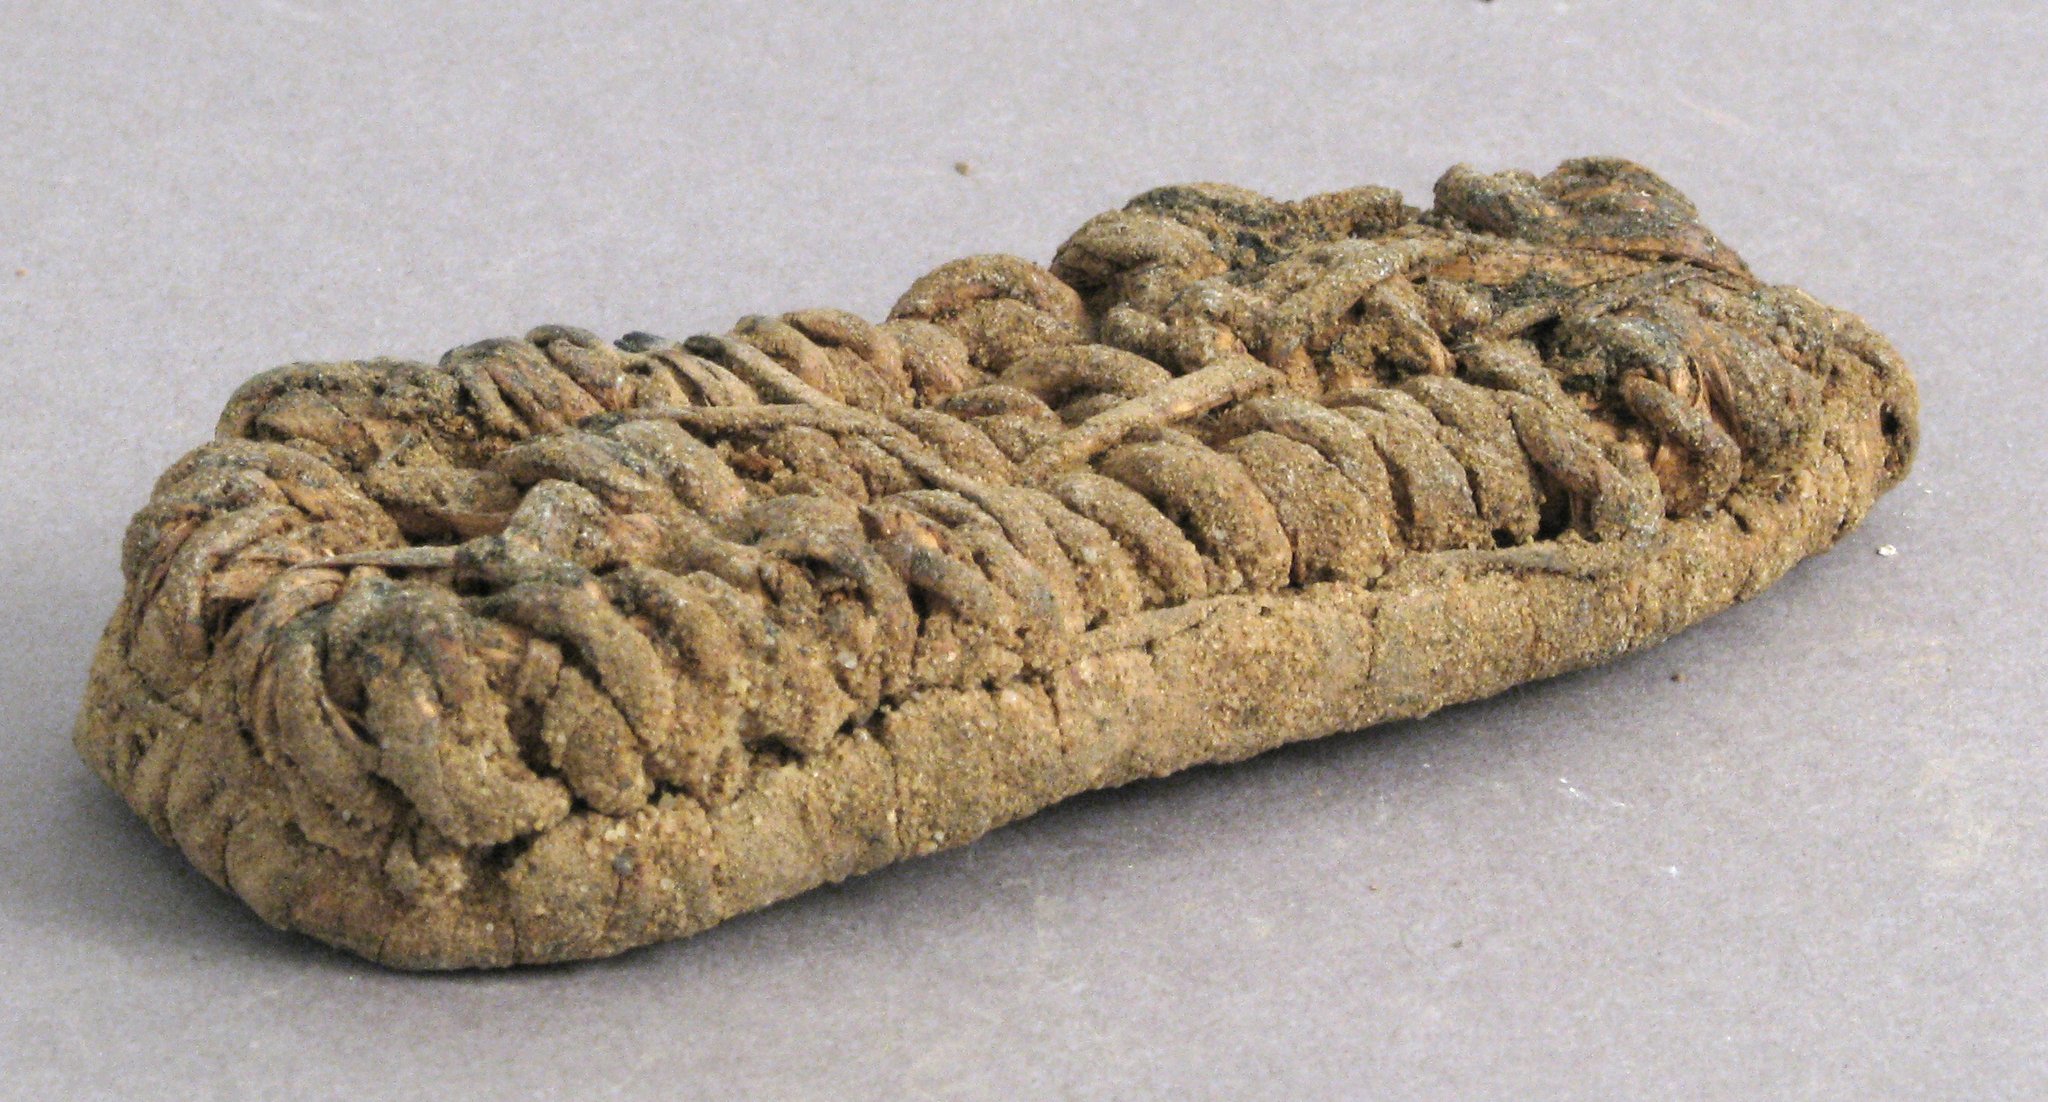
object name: sandal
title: Sandal for a Child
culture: coptic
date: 301-700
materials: hemp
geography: egypt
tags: footwear